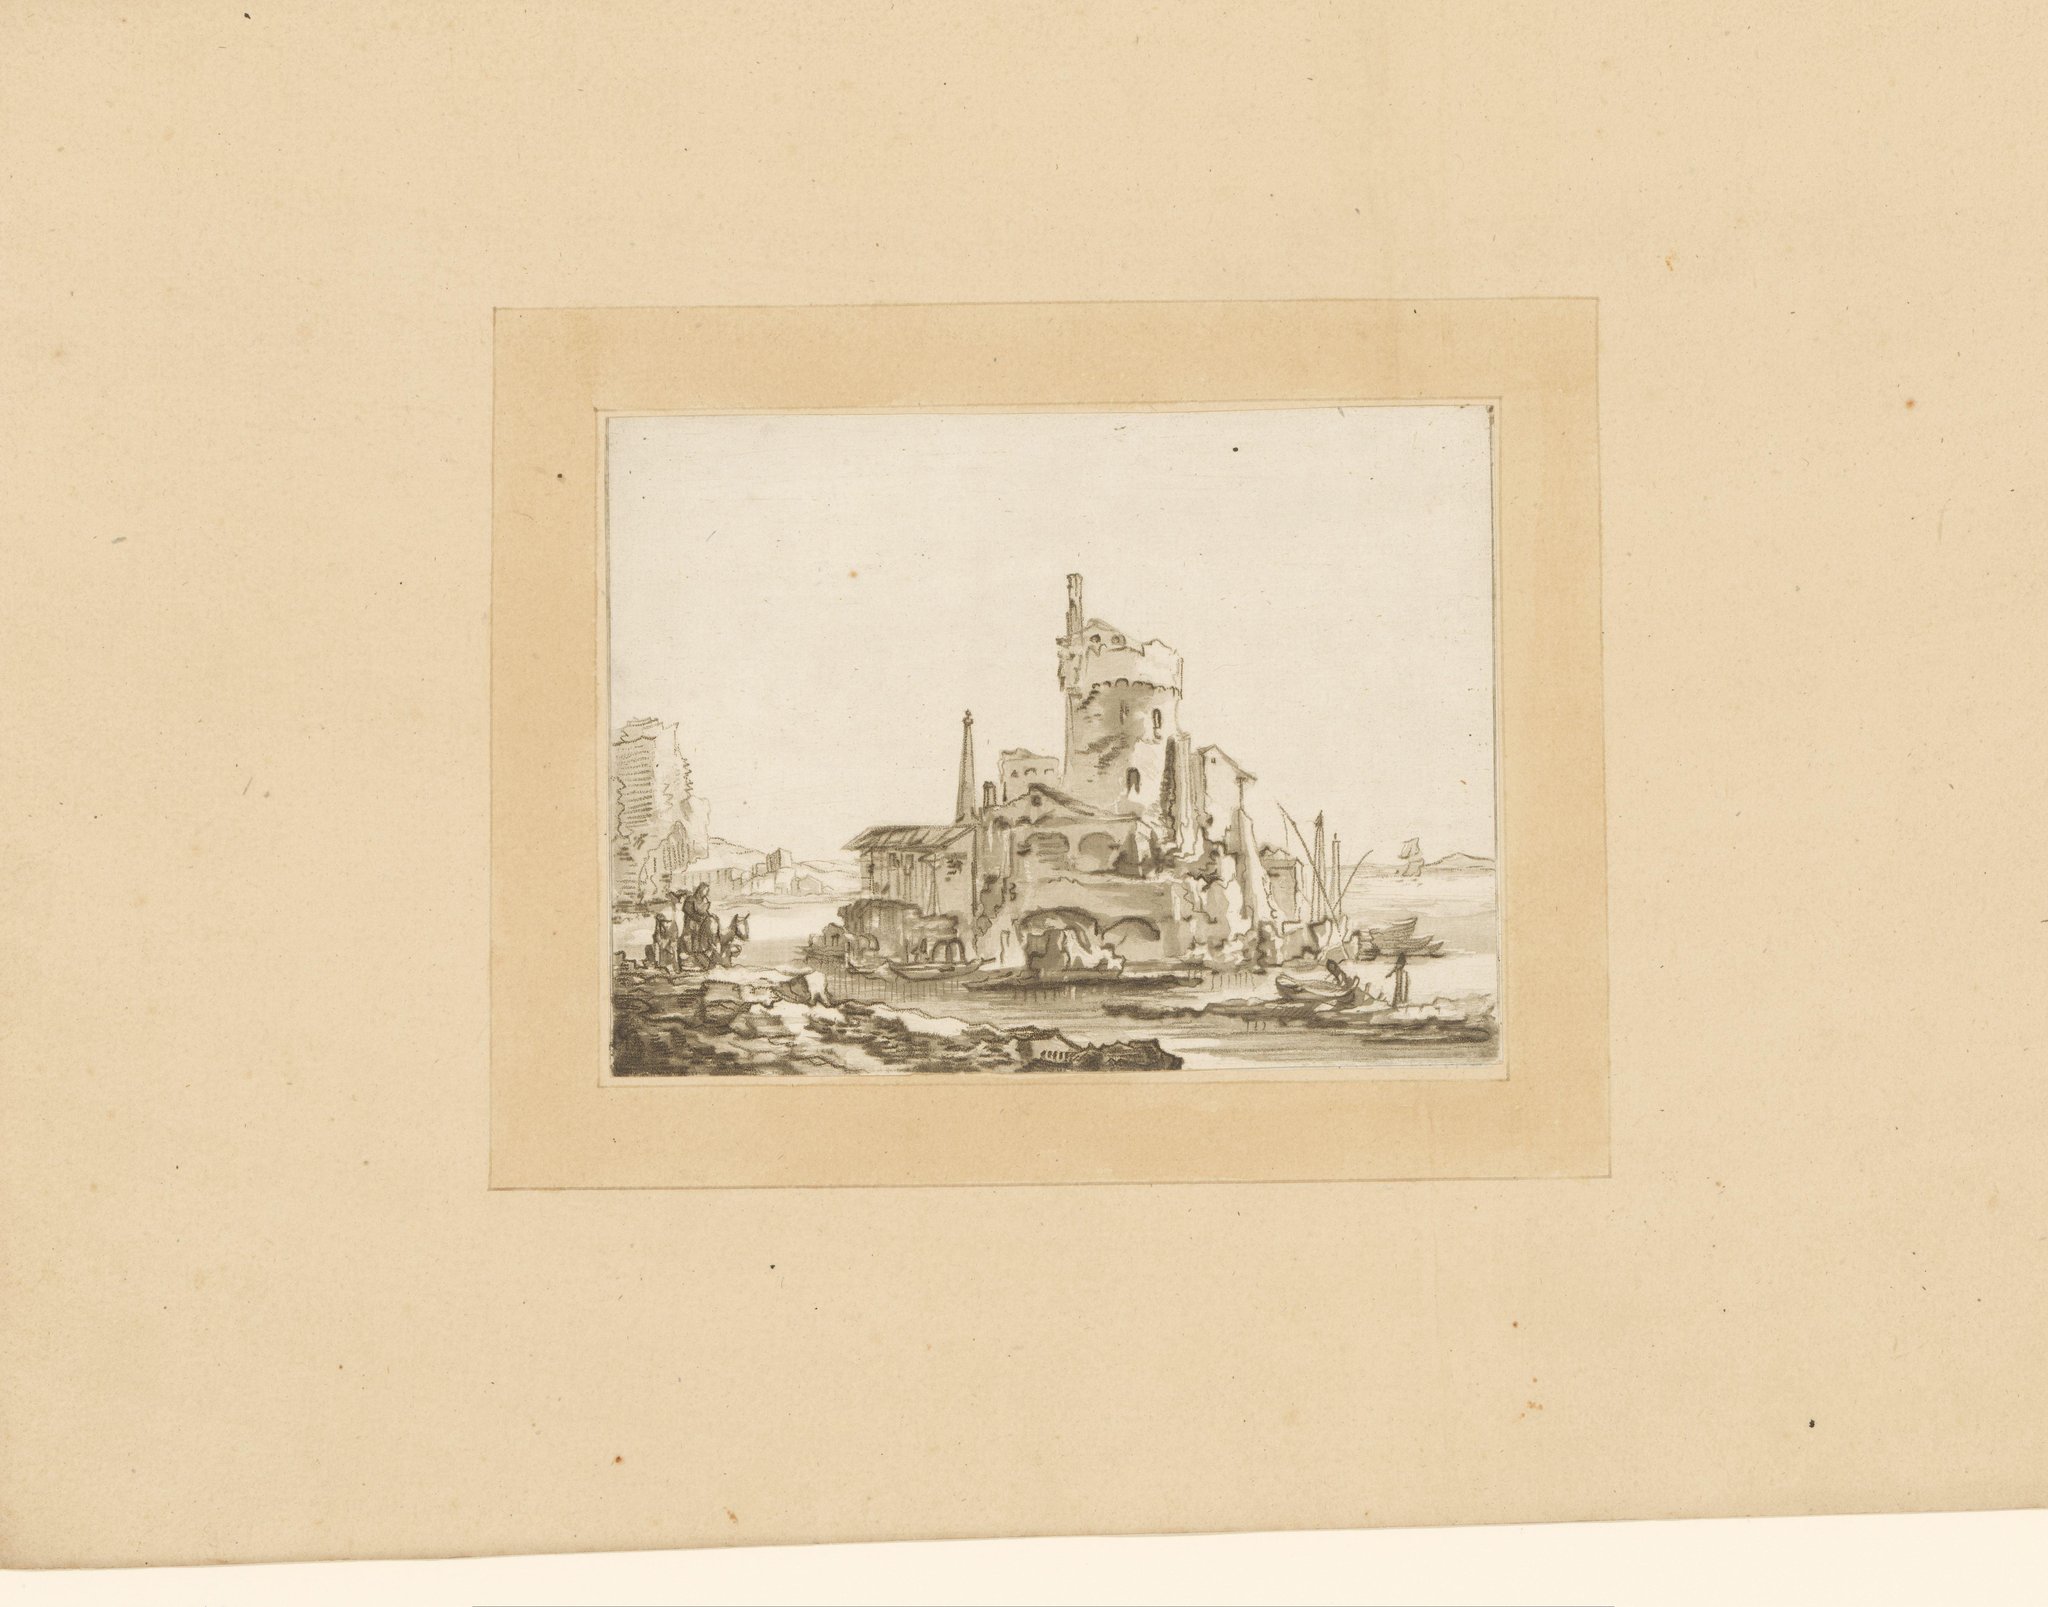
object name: print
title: Landschap met kasteel aan het water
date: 1783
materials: paper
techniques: aquatint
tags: castle, landscapes with waters, waterscapes, seascapes (in the temperate zone)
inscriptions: collector's mark: Lugt 2228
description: Nummer 17 uit het prentenalbum 'Dessins des meilleurs Peintres d'Italie, d'Allemagne, et des Pays-Bas, Tirés de divers célebres Cabinets. Gravés d'apres les Originaux de même grandeur par Jean Théophile Prestel'. Neurenberg: J.G. Prestel, 1783.